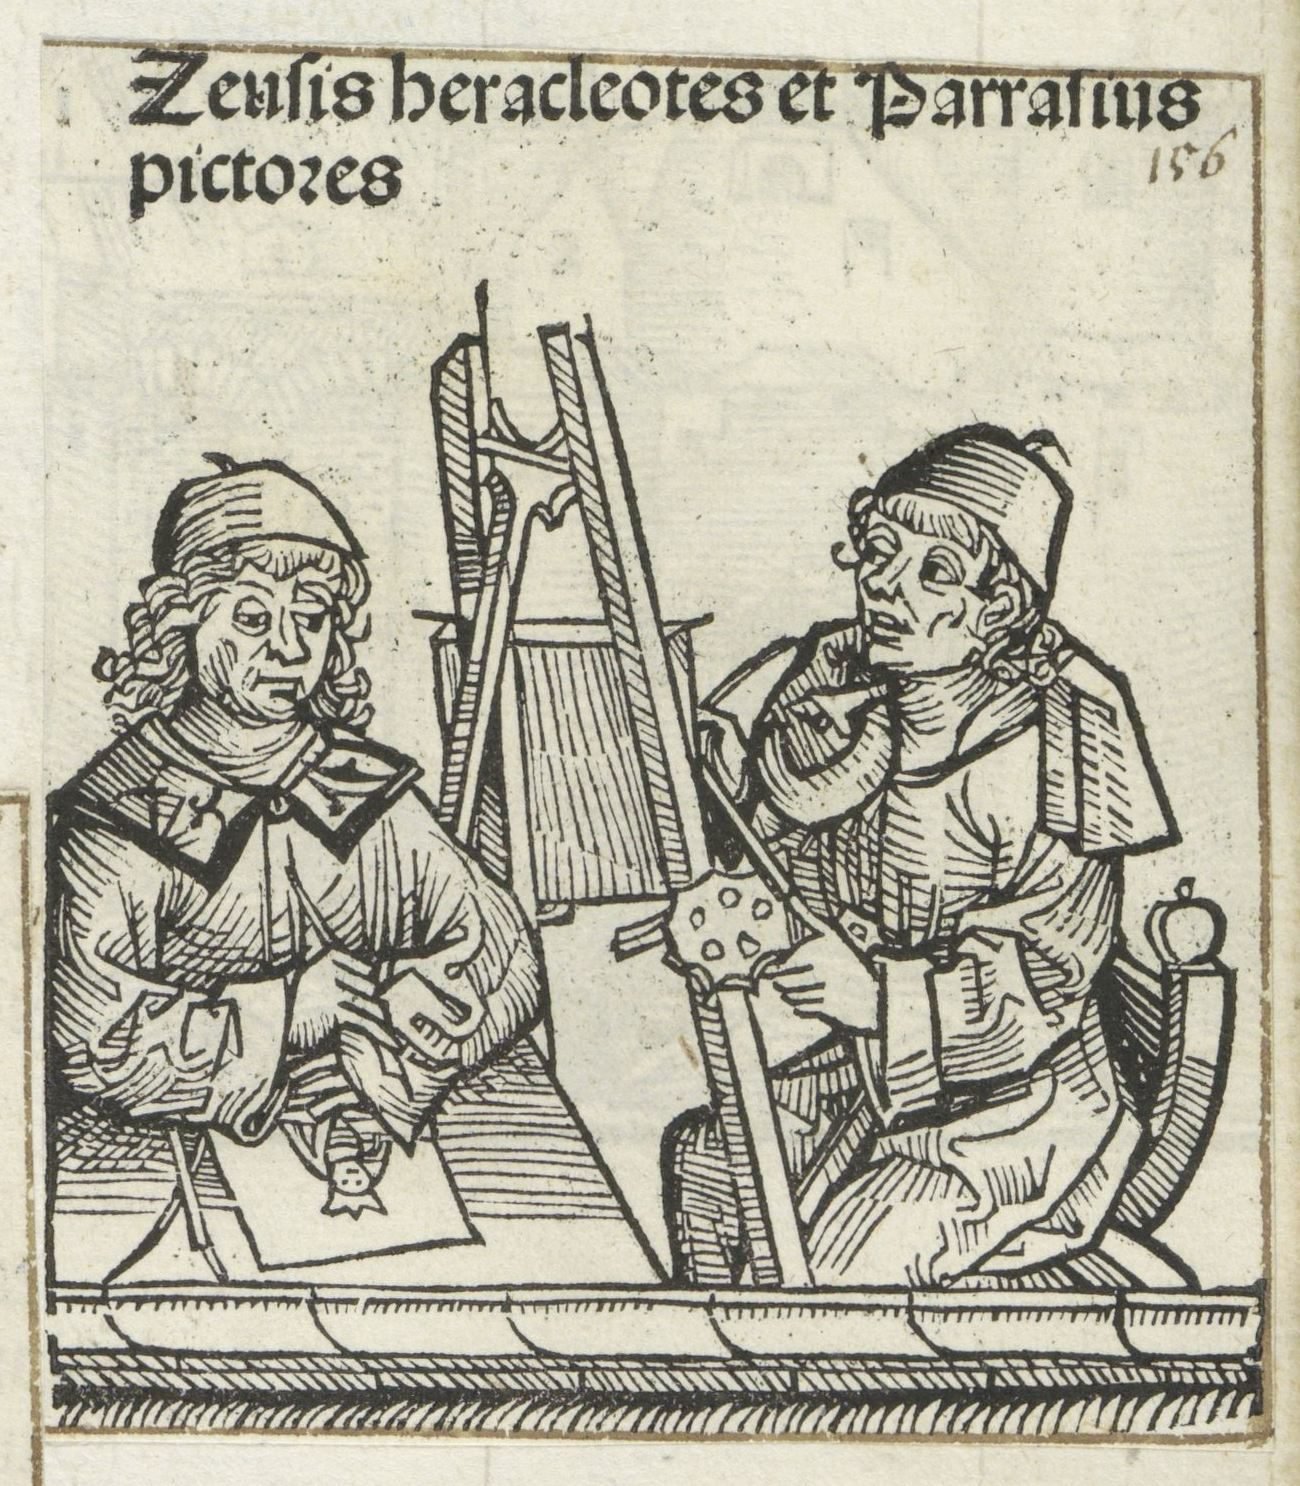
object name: print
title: Zeuxis en Parrhasius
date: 1493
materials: paper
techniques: letterpress printing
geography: nuremberg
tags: (story of) the painter zeuxis, parrhasius, the painter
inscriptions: inscription: ‘156’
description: De houtsnede wordt gebruikt als boekillustratie in de Liber Chronicarum (of Neurenbergkroniek) van Hartmann Schedel, verschenen in het Latijn en Duits in 1493. Zie de Latijnse uitgave, folio 71r.